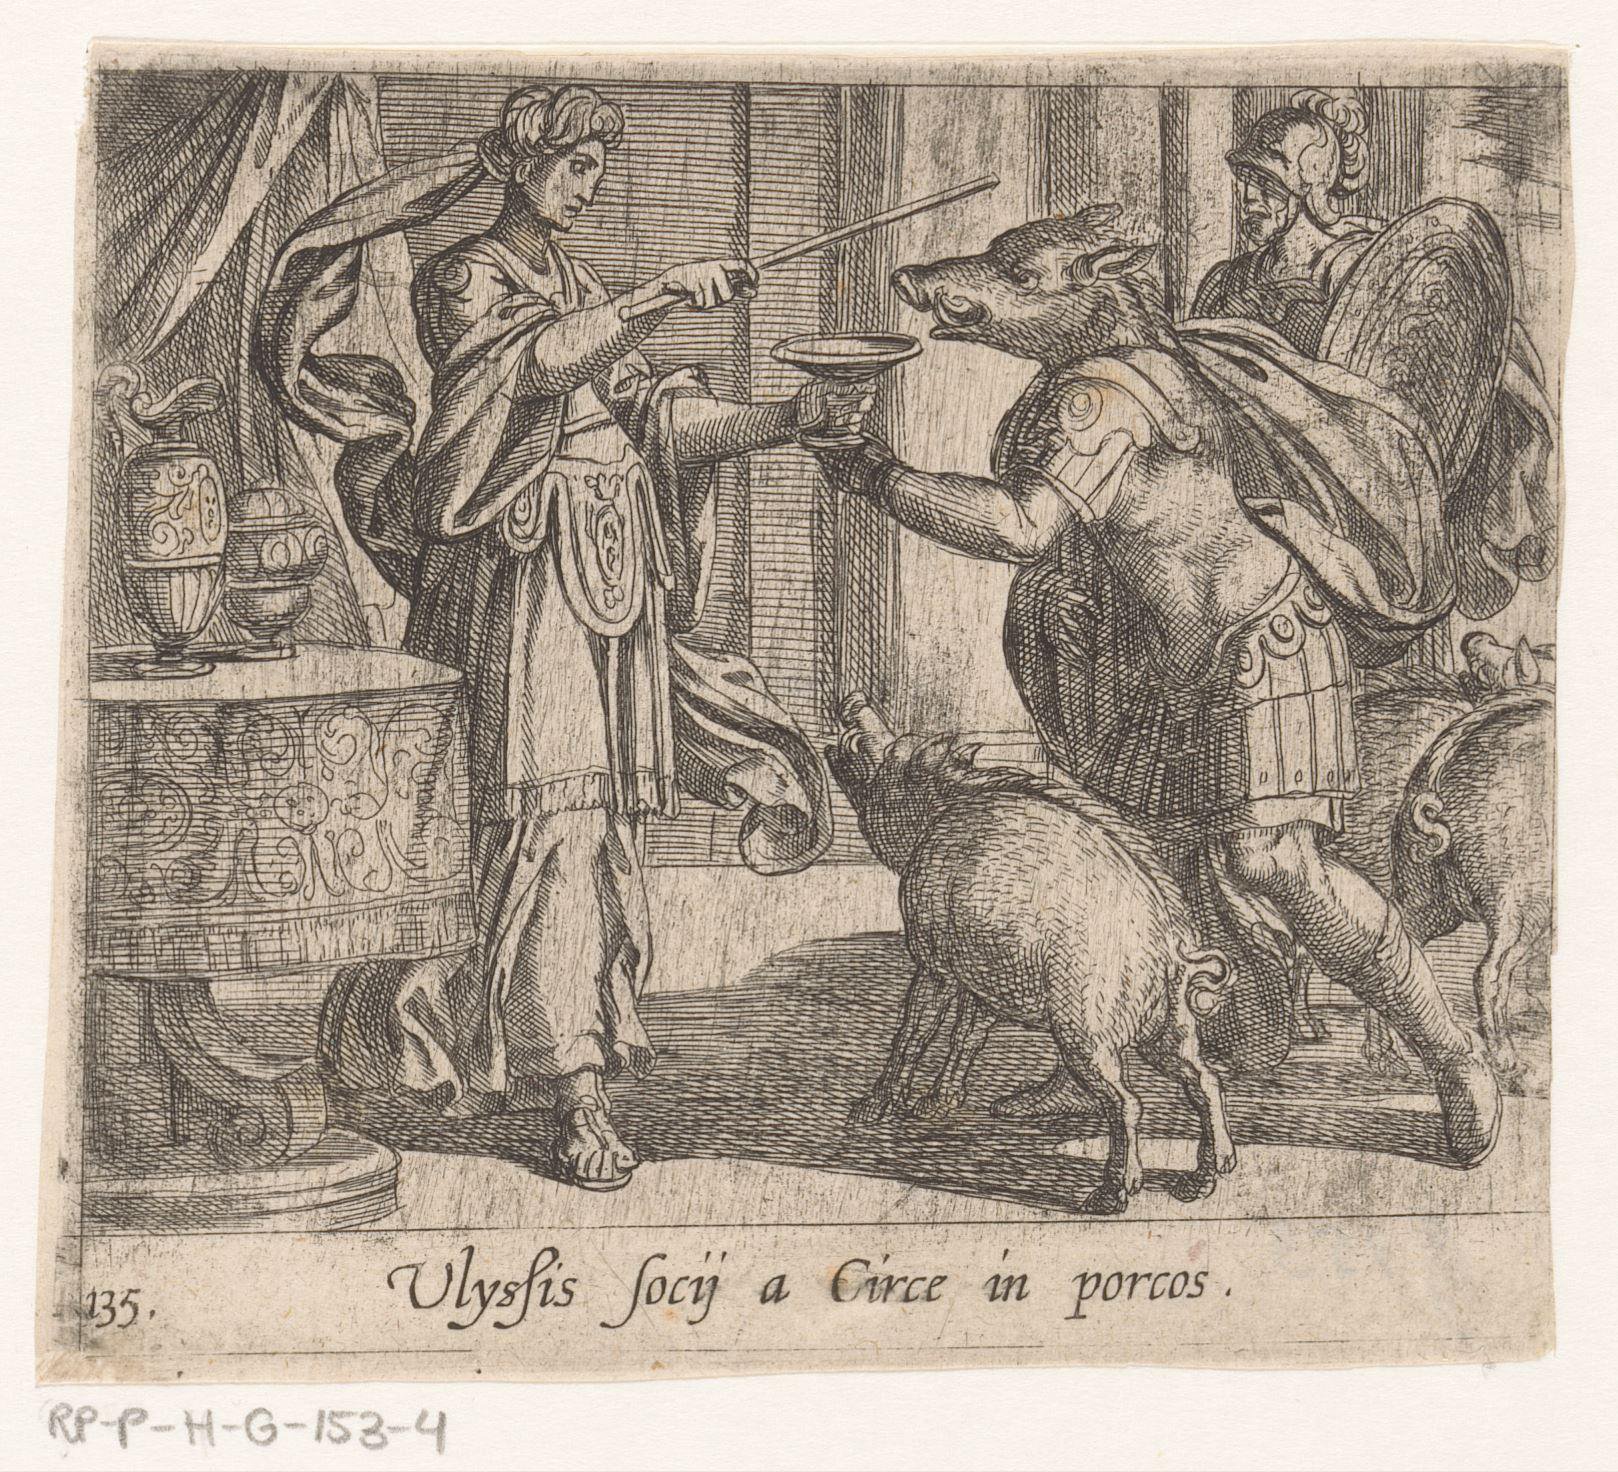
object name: print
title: Metamorfosen van Ovidius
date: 1606-1638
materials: paper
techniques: etching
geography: amsterdam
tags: ulysses' companions changed into swine: when they drink from the cup offered by circe, the enchantress, ulysses' companions change into swine (ovid, metamorphoses xiv 276)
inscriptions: collector's mark: ‘Hinloopen’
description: Deze prent maakt deel uit van een reeks van 150 prenten (+ titelprent) met voorstellingen van de Metamorfosen van Ovidius.